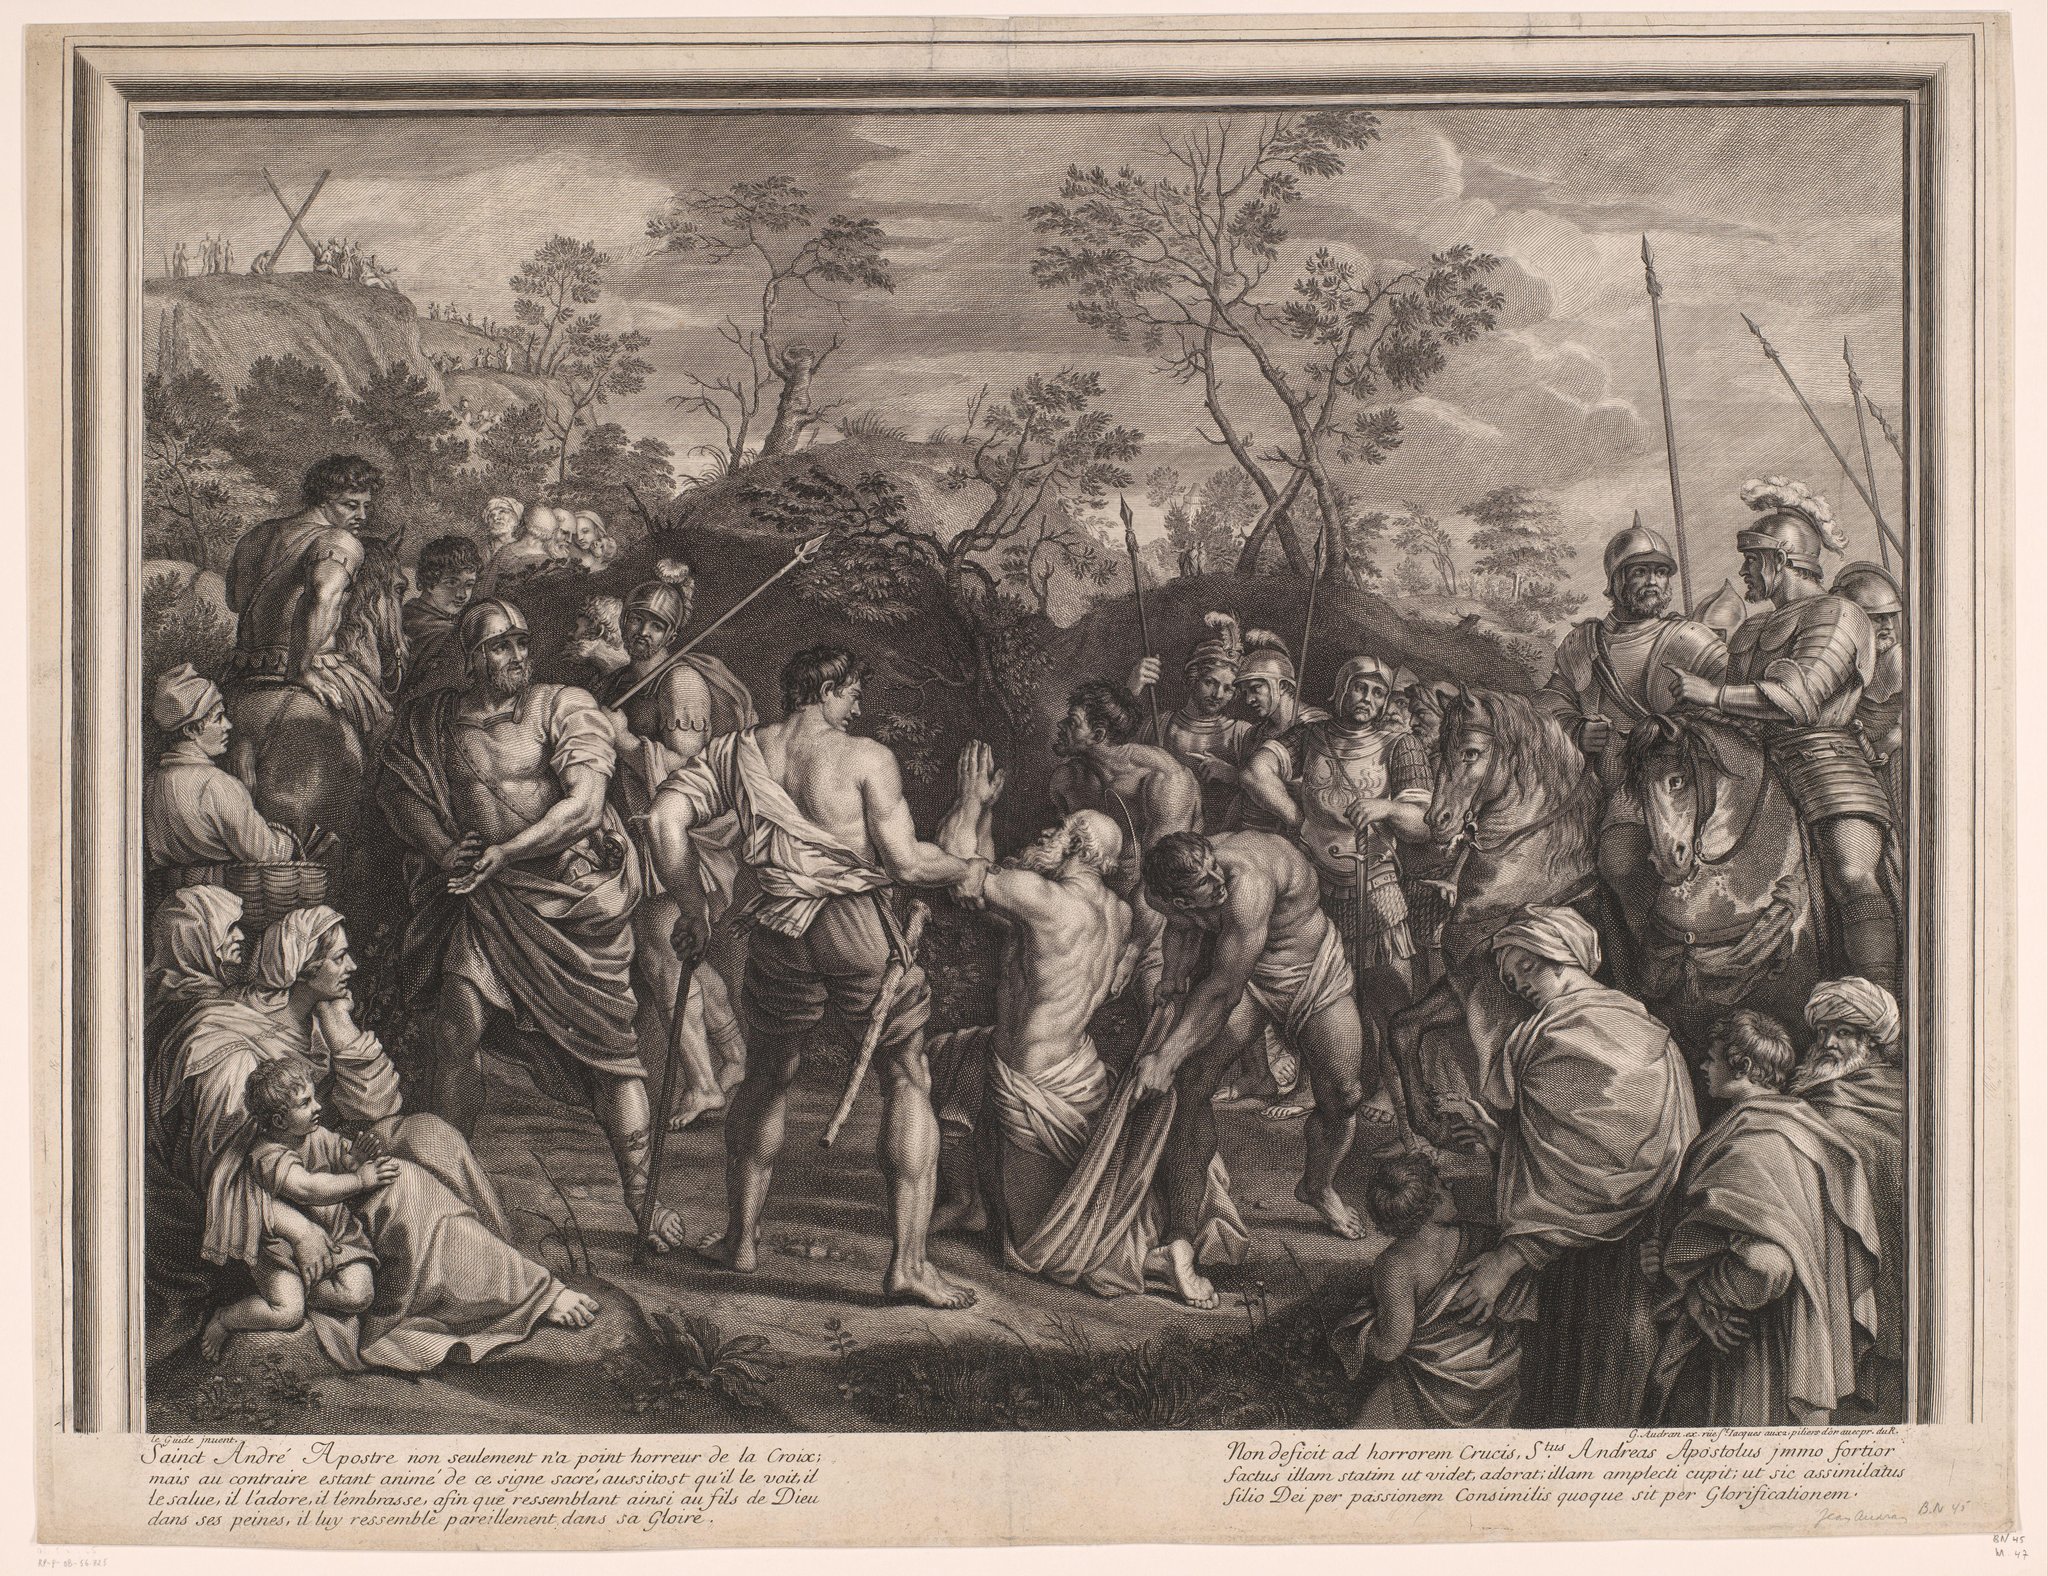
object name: print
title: H. Andreas wordt naar zijn kruisdood gevoerd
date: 1677-1756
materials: paper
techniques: engraving, etching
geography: paris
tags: the apostle andrew; possible attributes: book, x-shaped cross, fish, fishing-net, rope, scroll - martyrdom, suffering, misfortune, death of male saint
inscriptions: collector's mark: Lugt 2228